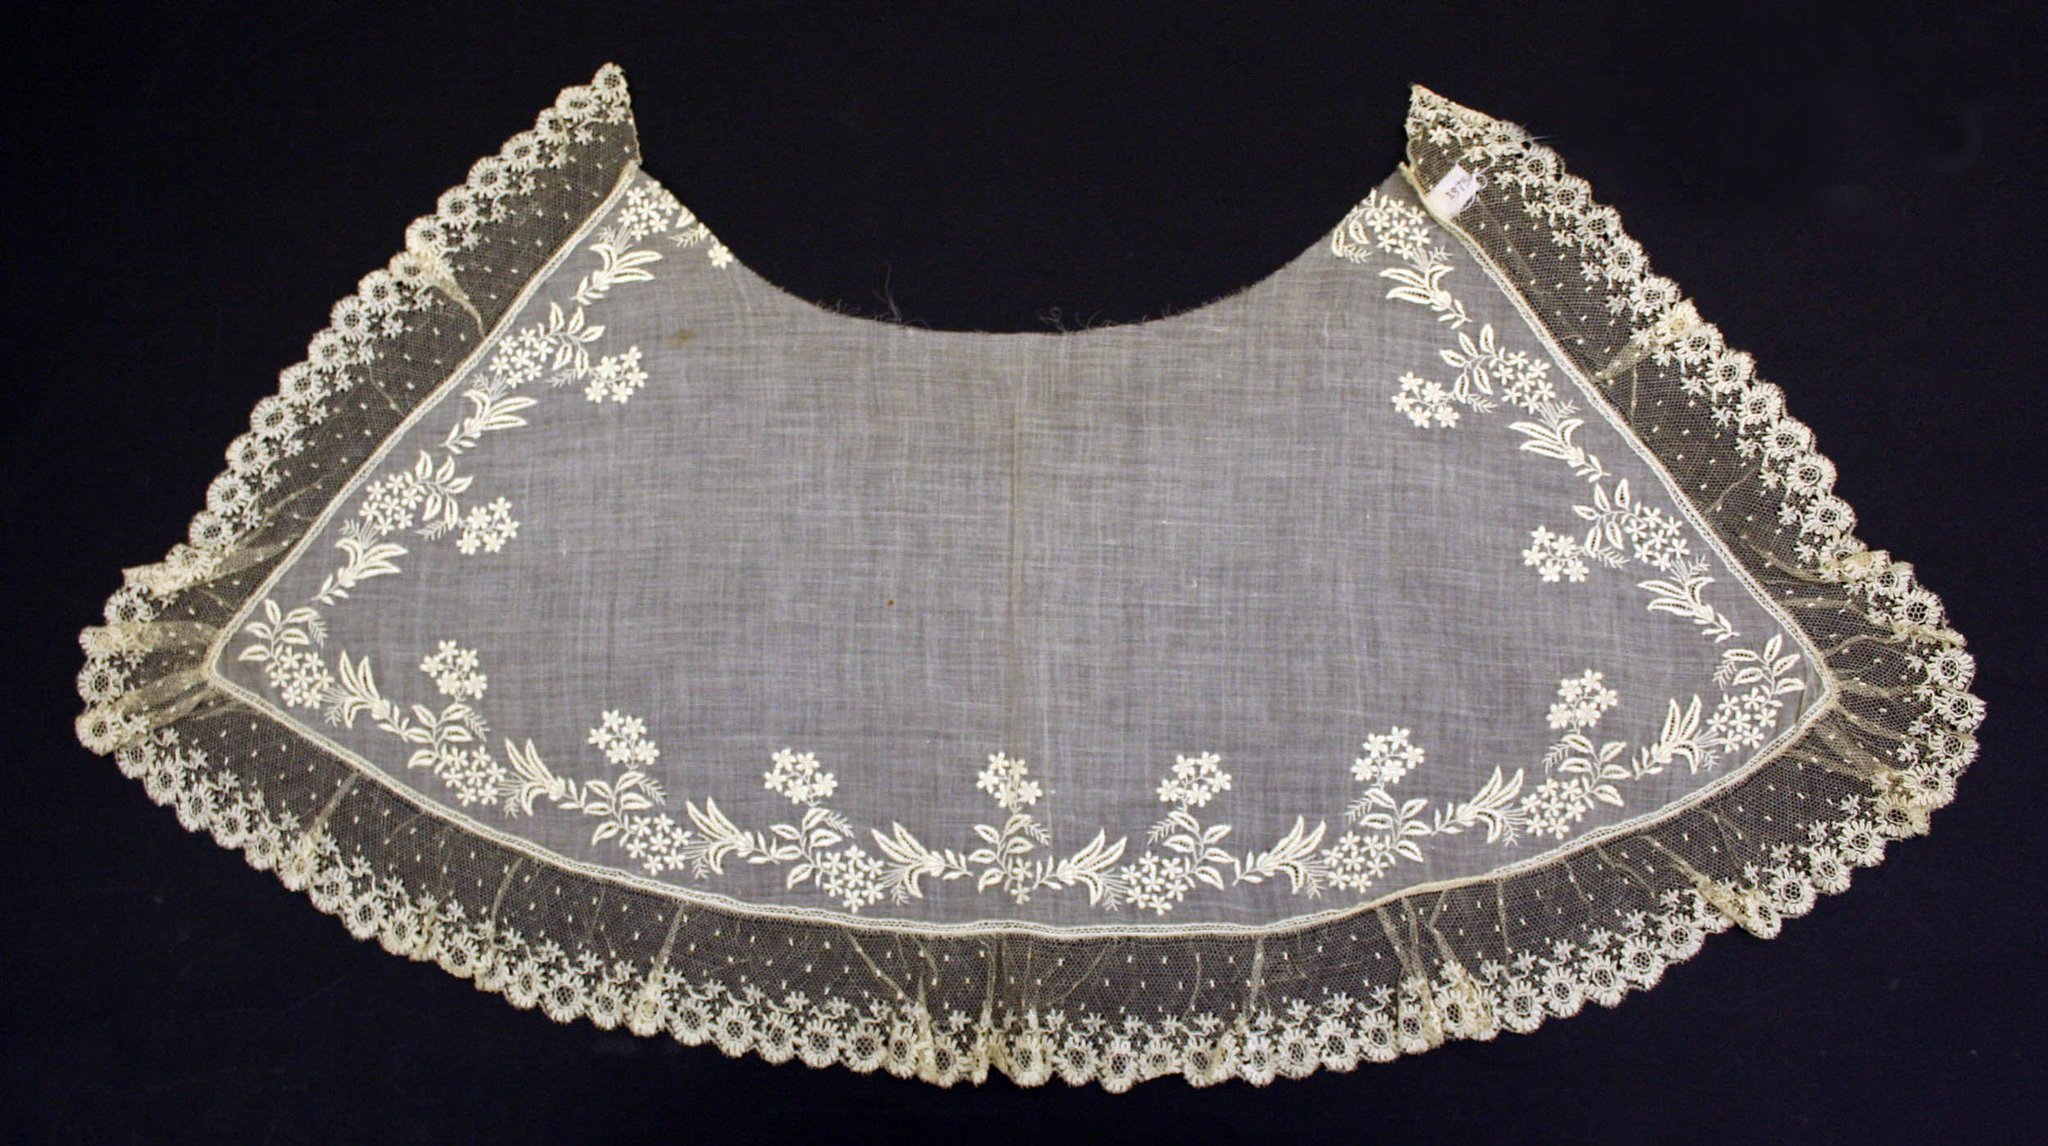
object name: collar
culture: american or european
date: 1834-1866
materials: cotton